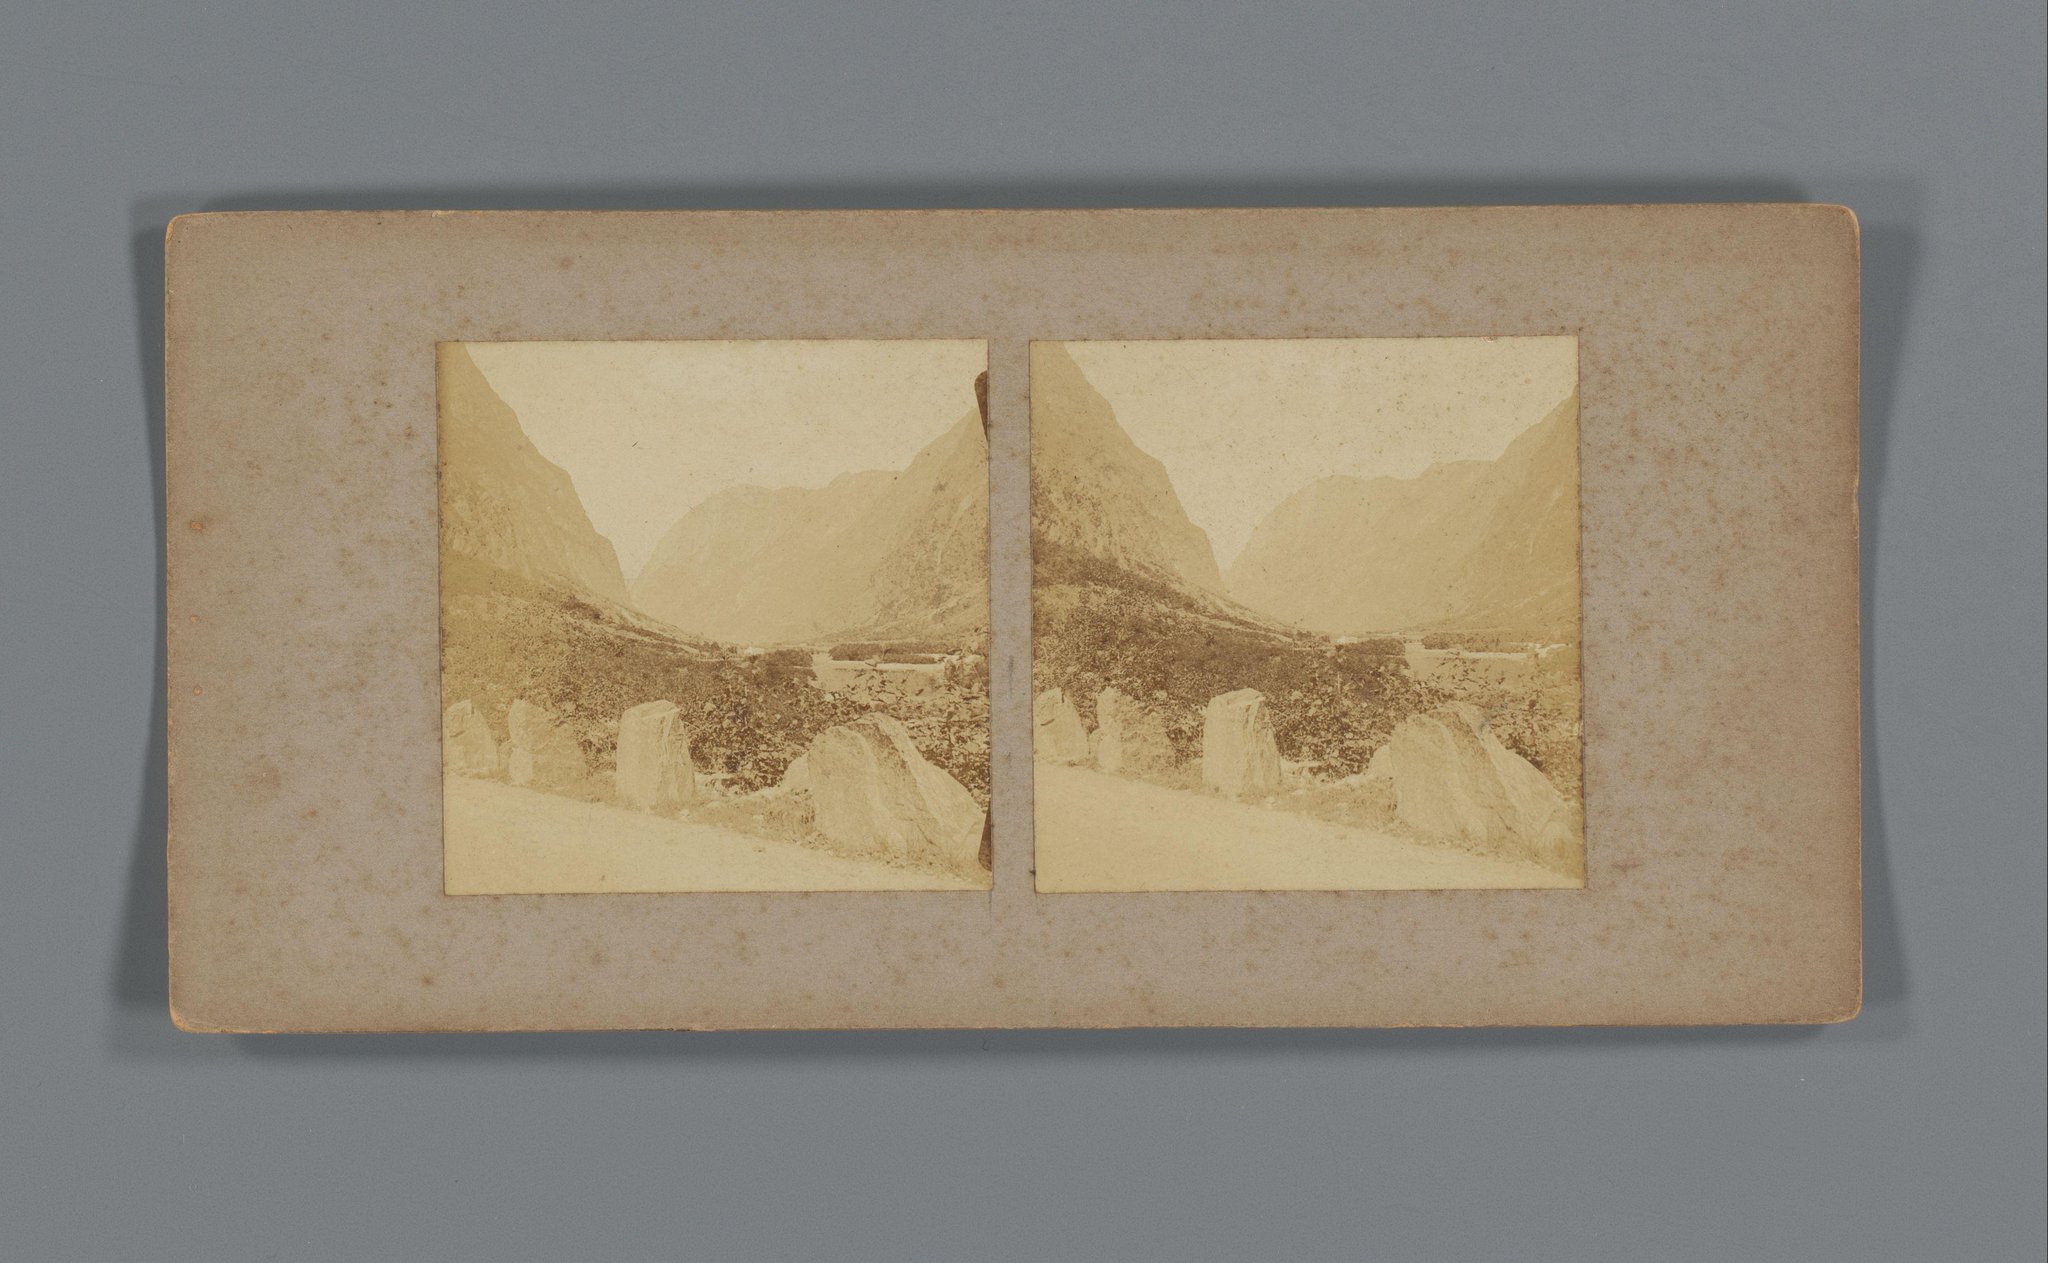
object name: stereograph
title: Gezicht op de Nærøyfjord in Noorwegen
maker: Anonymous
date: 1882-1890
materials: cardboard, photographic support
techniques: collodion silver print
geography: nærøyfjord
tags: dale, valley